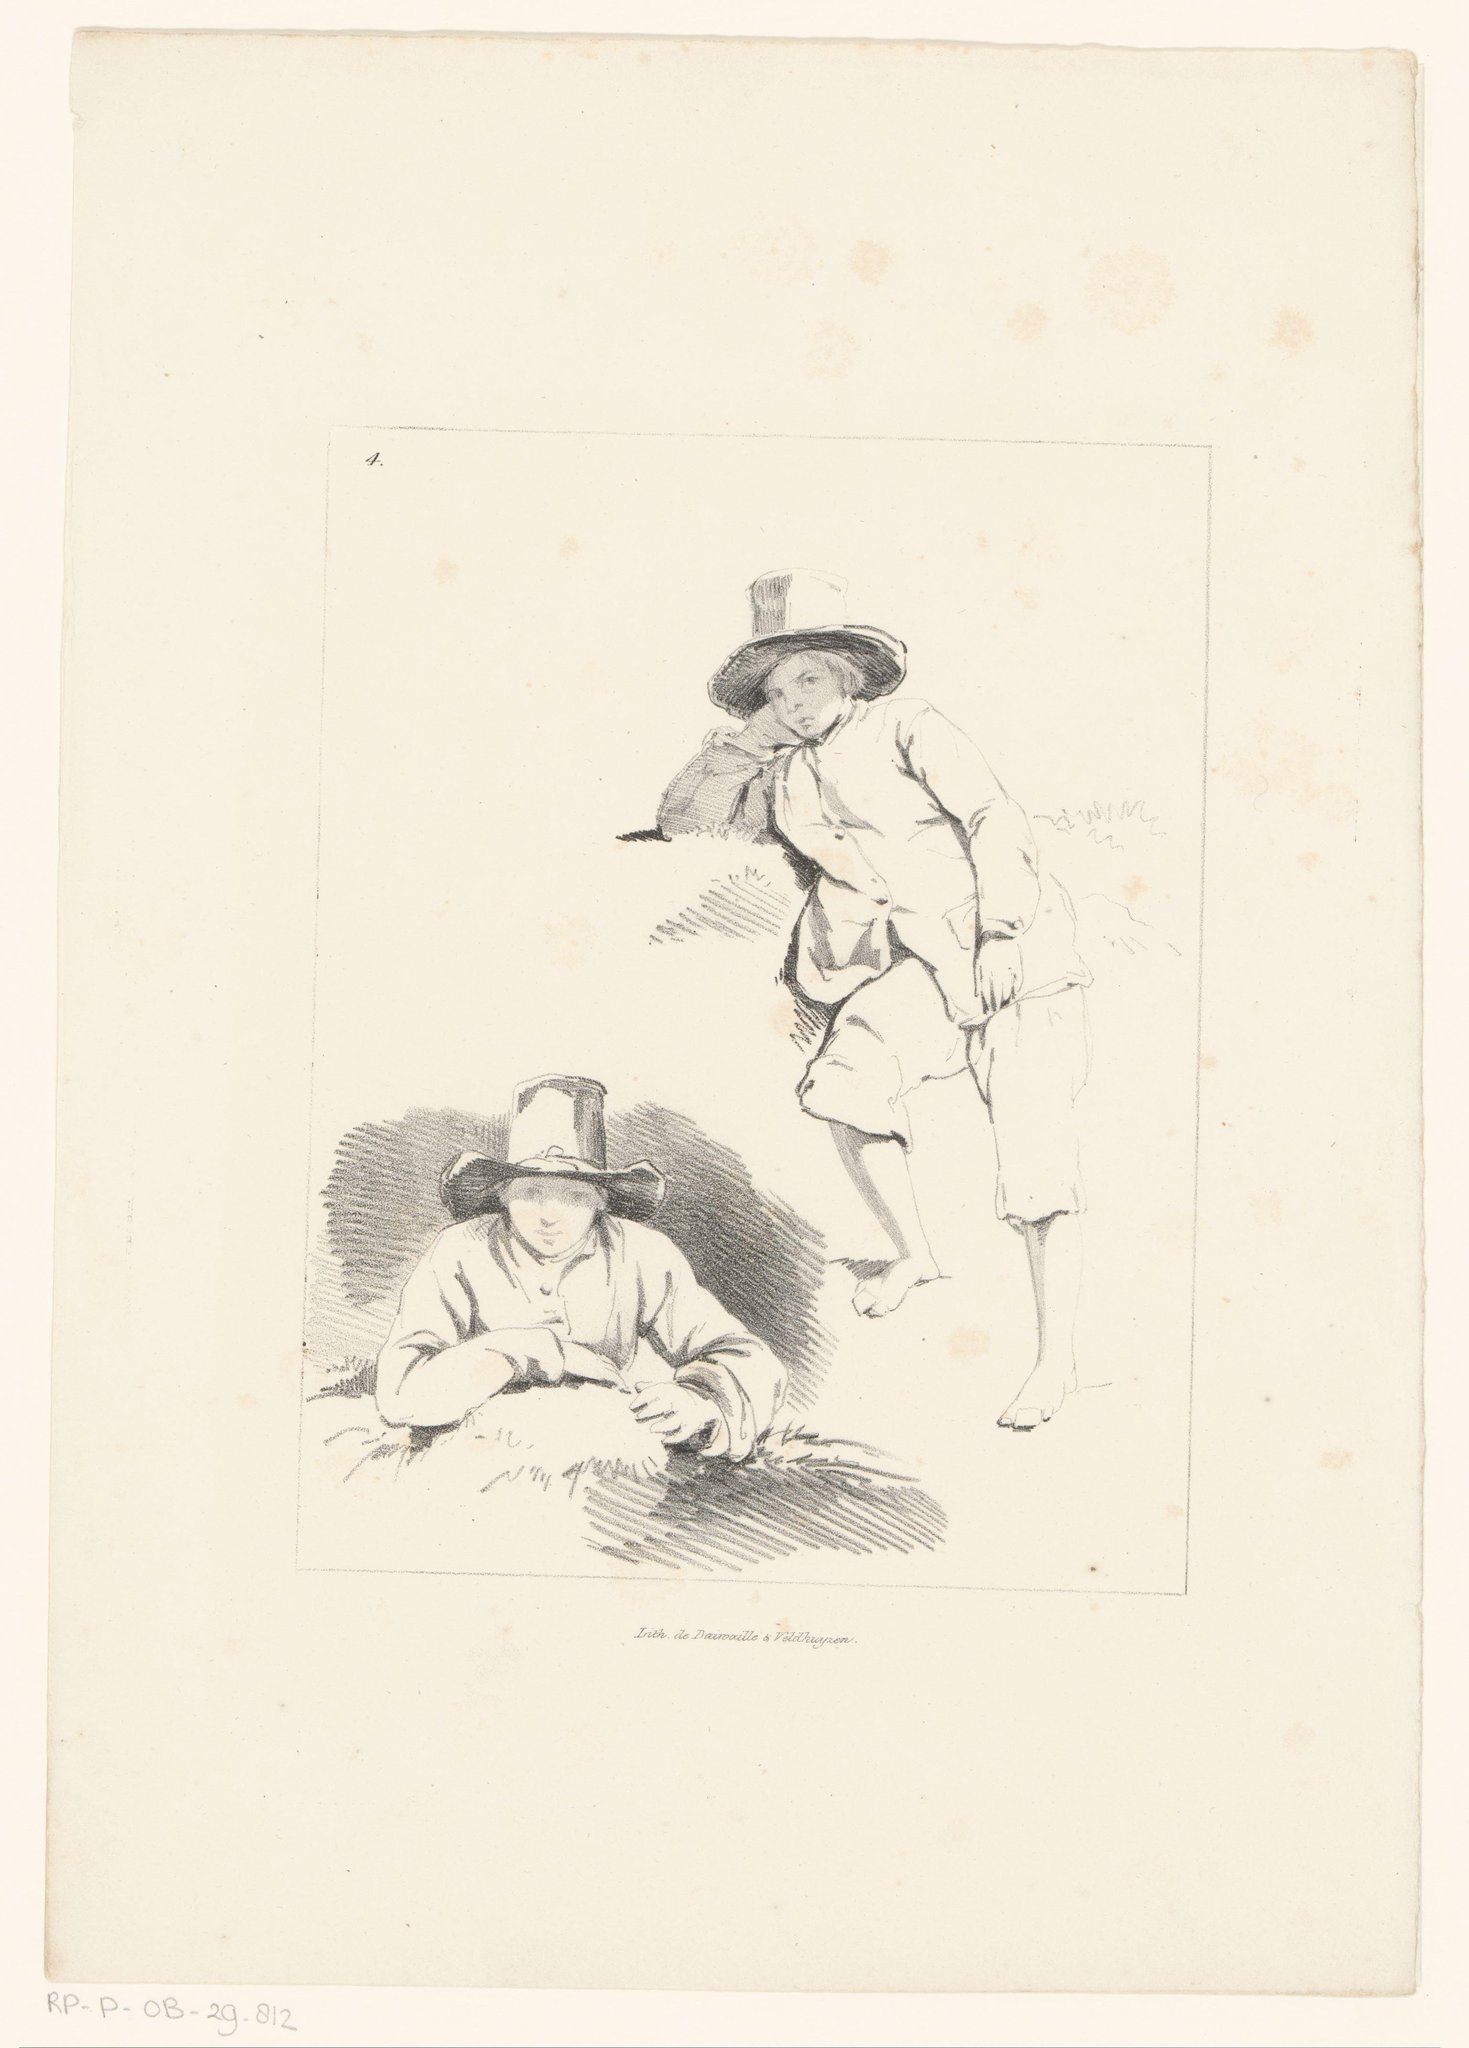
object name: print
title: Jongeman met hoed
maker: Anonymous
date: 1831-1832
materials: paper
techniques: lithograph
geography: netherlands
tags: youth, adolescent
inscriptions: collector's mark: Lugt 2228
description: Studieblad met twee maal een jongeman met hoed.